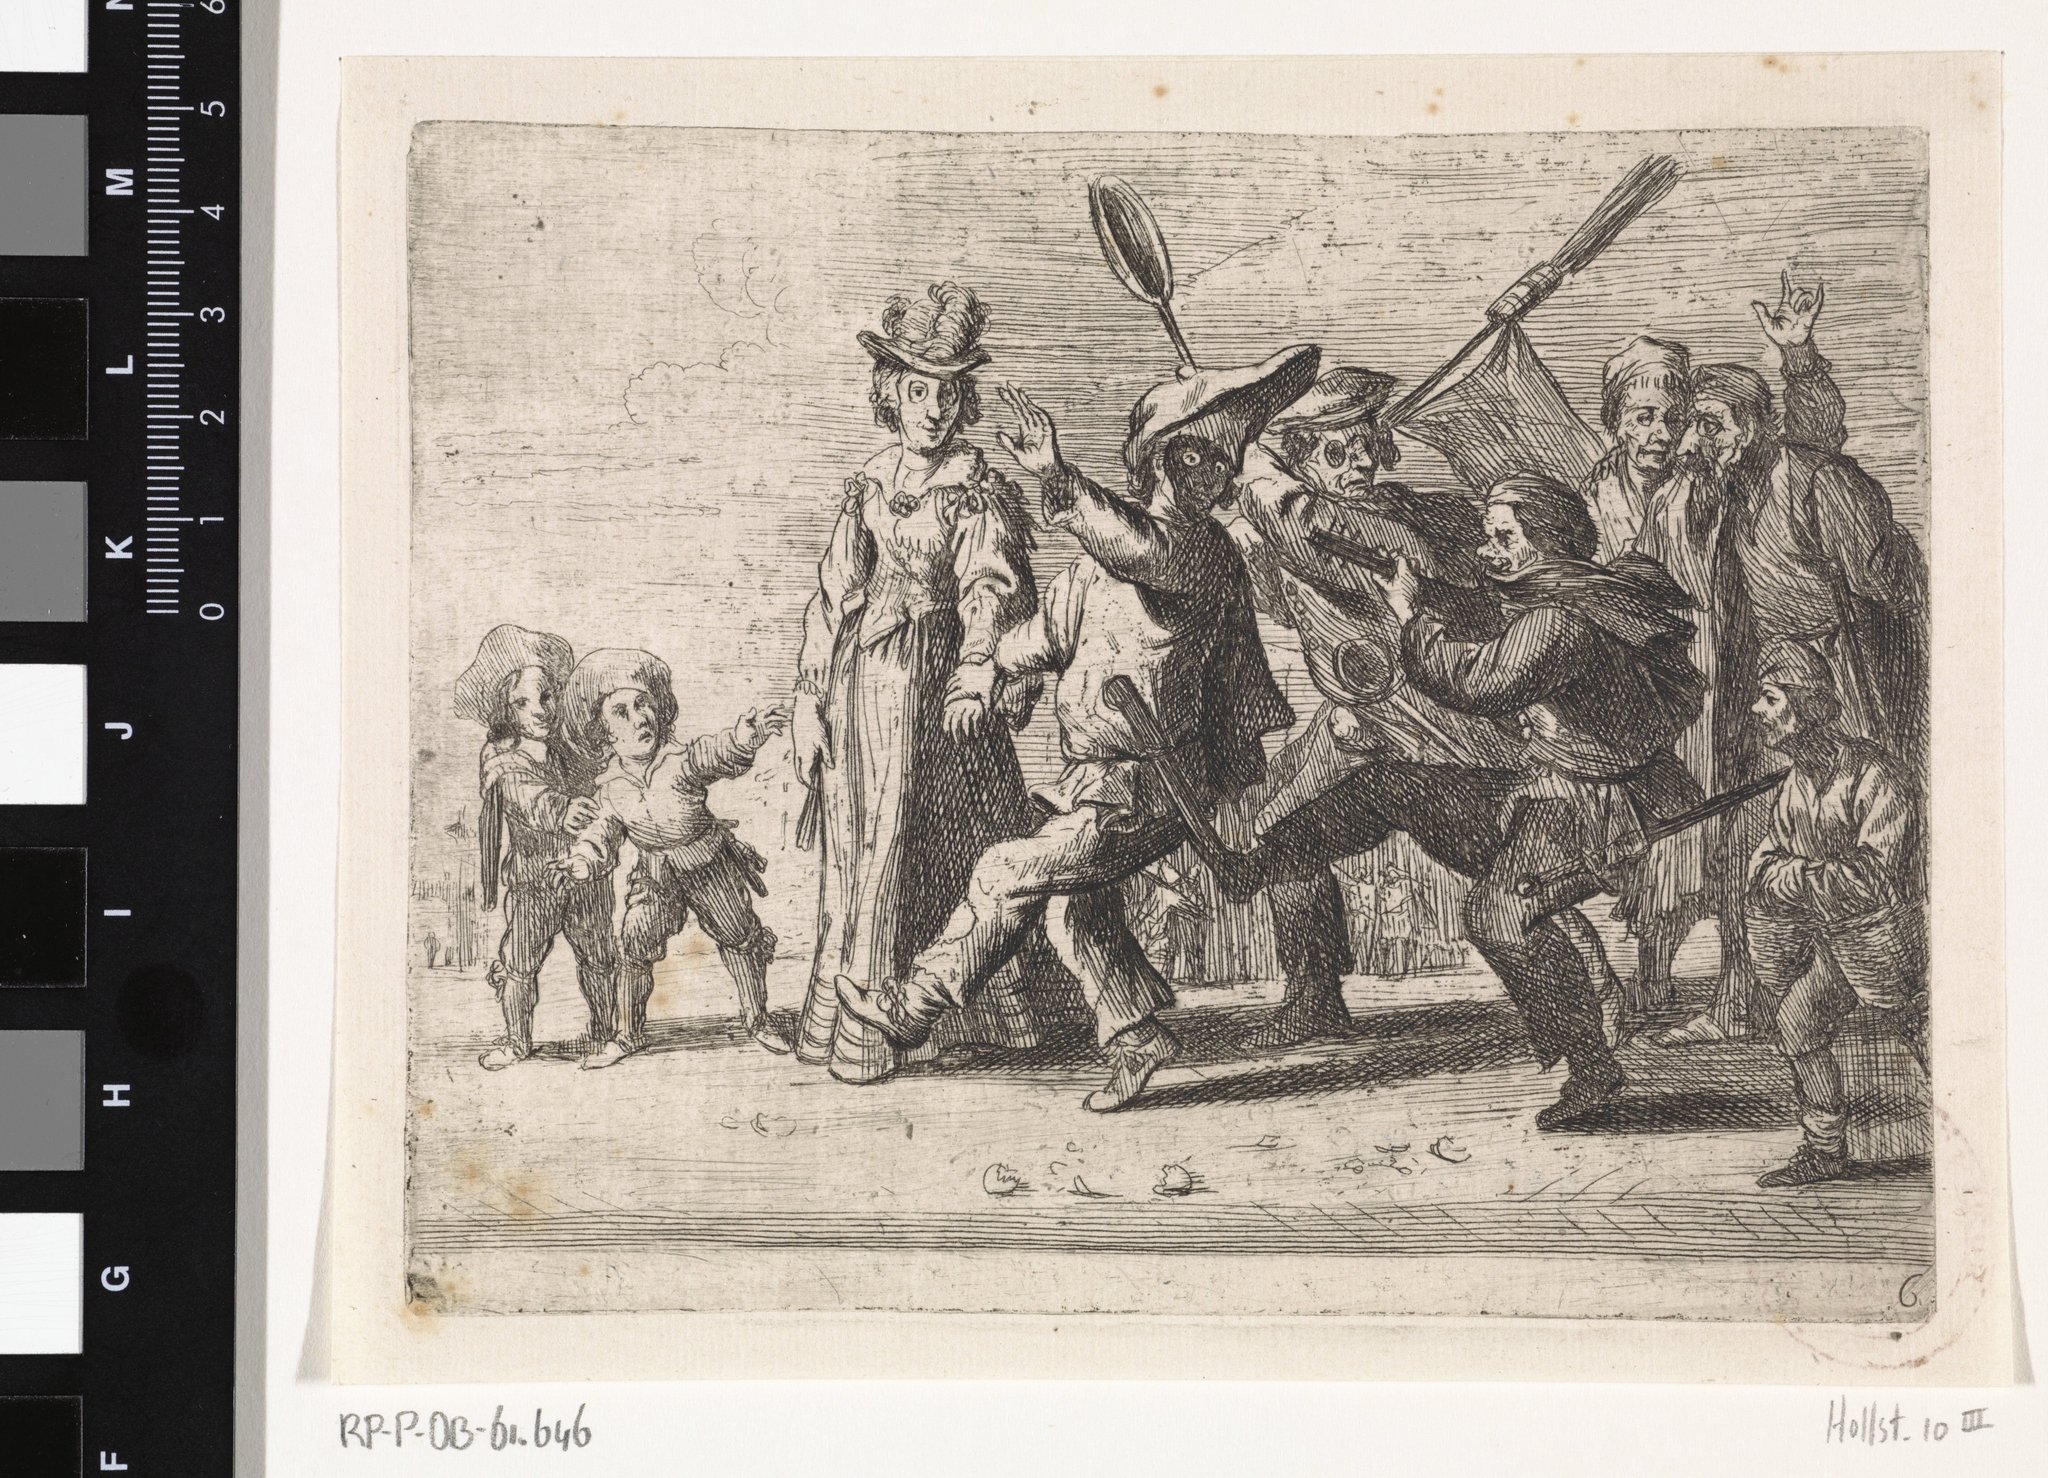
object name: print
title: De maskerade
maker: cornelis de wael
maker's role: draughtsman, print maker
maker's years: 1592-1667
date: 1630-1648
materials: paper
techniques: engraving, etching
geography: italy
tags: kitchen-utensils: pan, little people, masquerade, masked ball, (household) utensils and implements (with name)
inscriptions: collector's mark: Lugt 240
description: Een optocht van gemaskerde mannen en een vrouw. Eén van hen houdt een bezemsteel in de hand, een ander een koekenpan. Twee kleine mensen kijken toe. Op de voorgrond gebroken eierschalen.